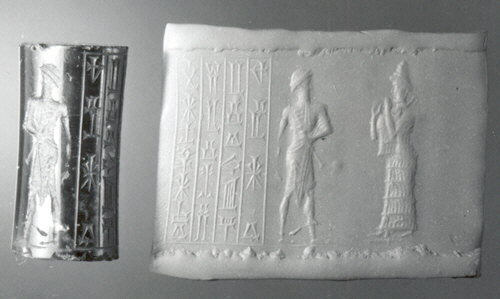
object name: cylinder seal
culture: isin-larsa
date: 1822-1763 BCE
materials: gemstone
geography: mesopotamia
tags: men,women